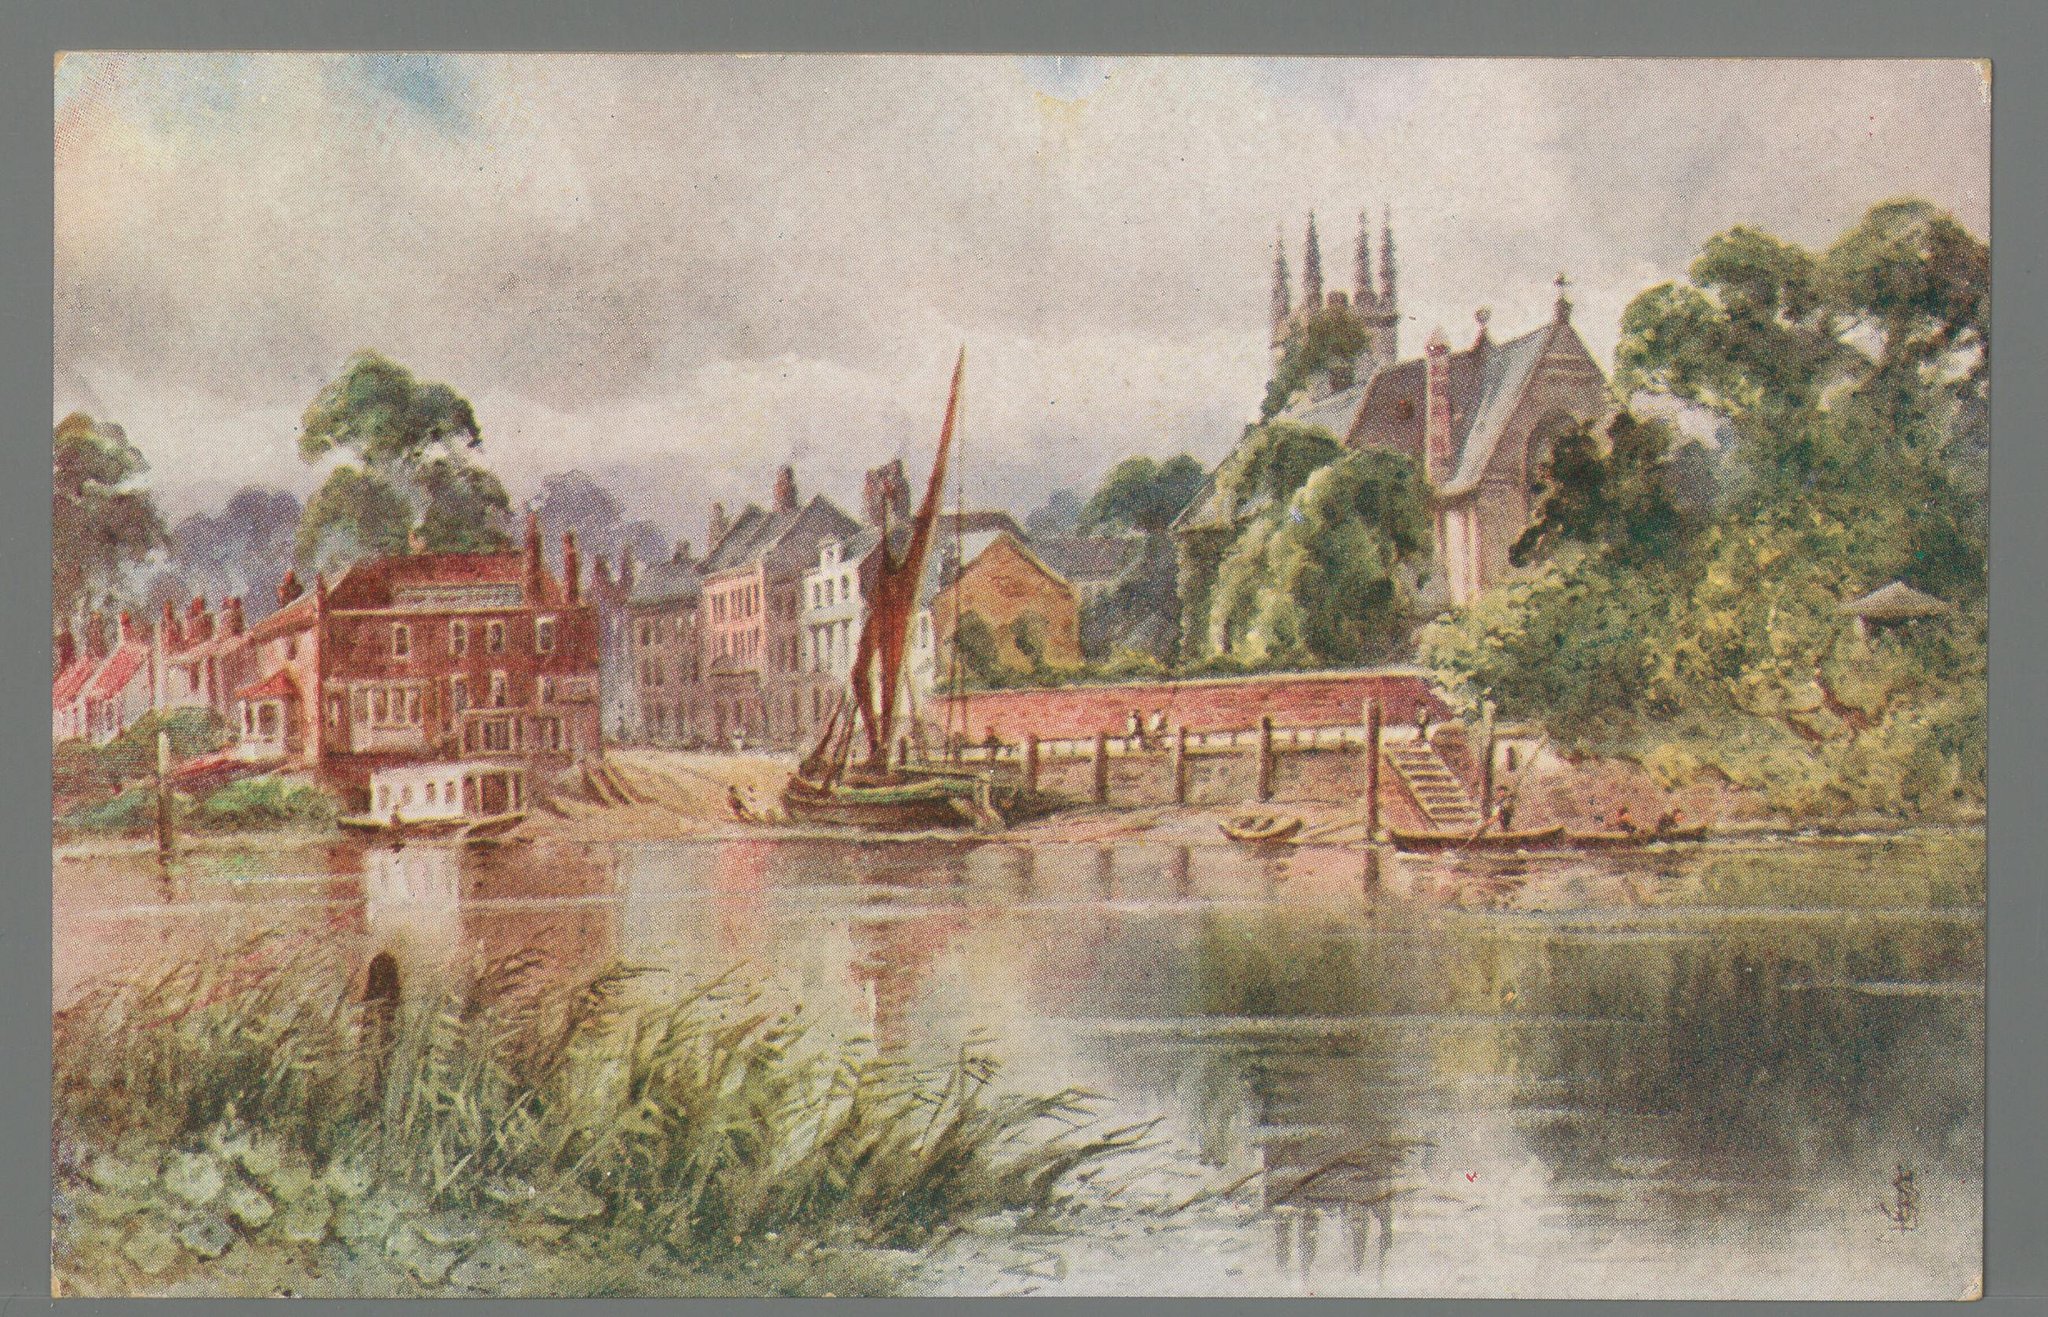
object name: ansichtkaart, prentbriefkaart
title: Isleworth (River Thames)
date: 1902-1930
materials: cardboard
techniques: color autotype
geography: richmond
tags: city-view, and landscape with man-made constructions, river, thames